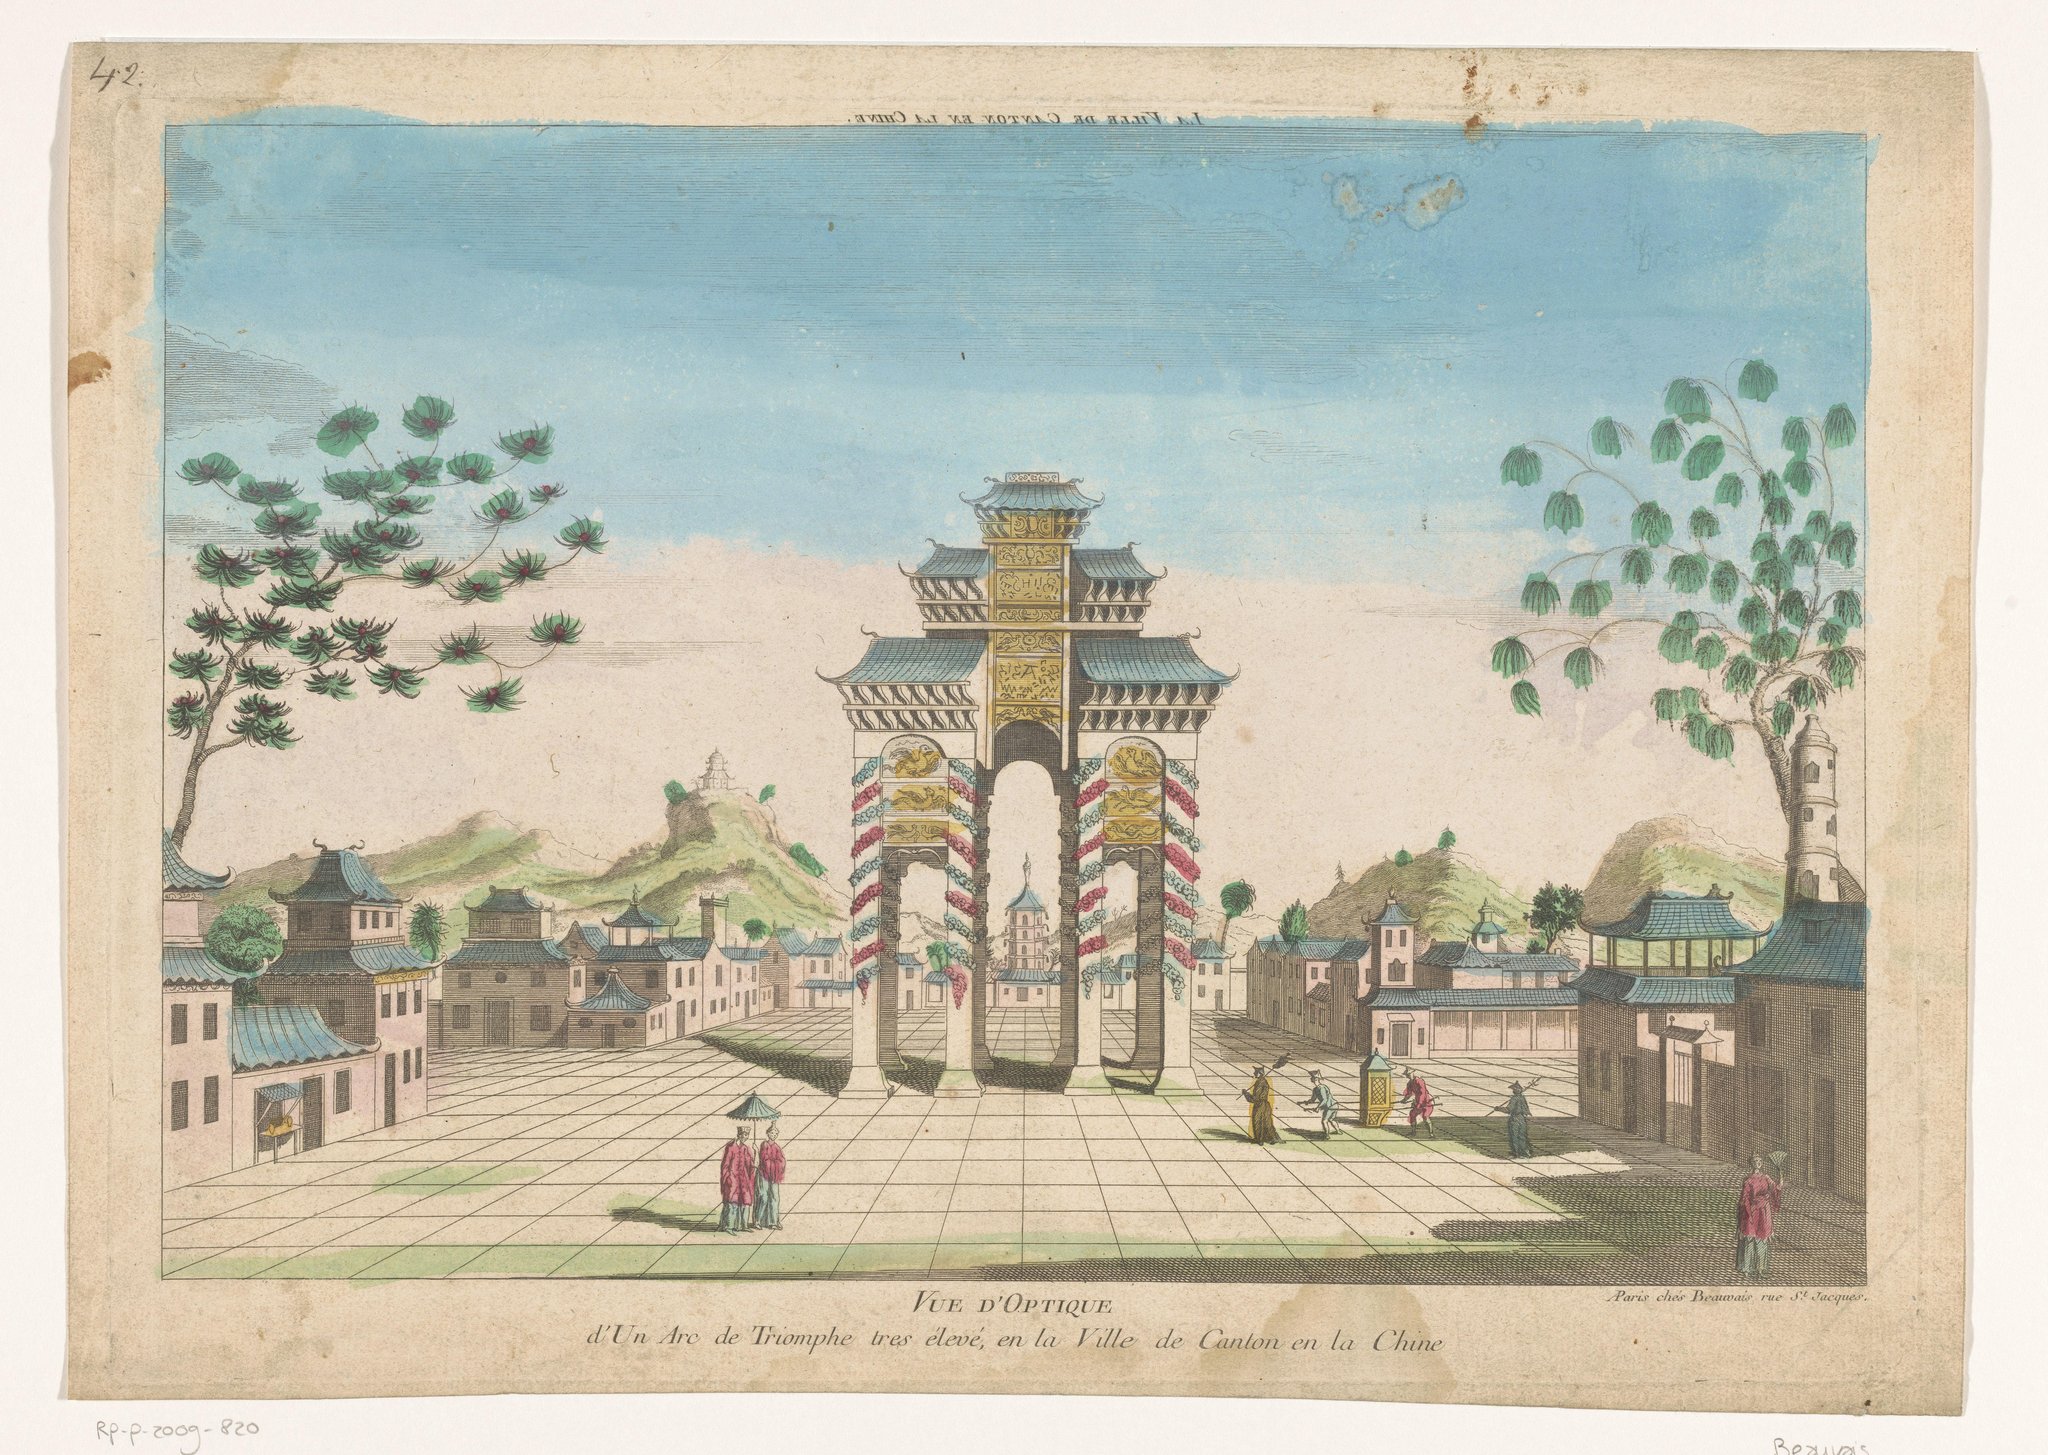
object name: opticaprent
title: La ville de Canton en la Chine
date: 1700-1799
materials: paper, watercolor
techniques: brush, etching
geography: paris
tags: kanton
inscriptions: watermark, collector's mark: Lugt 2228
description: Gezicht op een groot plein omgeven door gebouwen, daarachter bergen. In het midden een hoge poort met drie doorgangen. Enkele mensen en een draagkoets